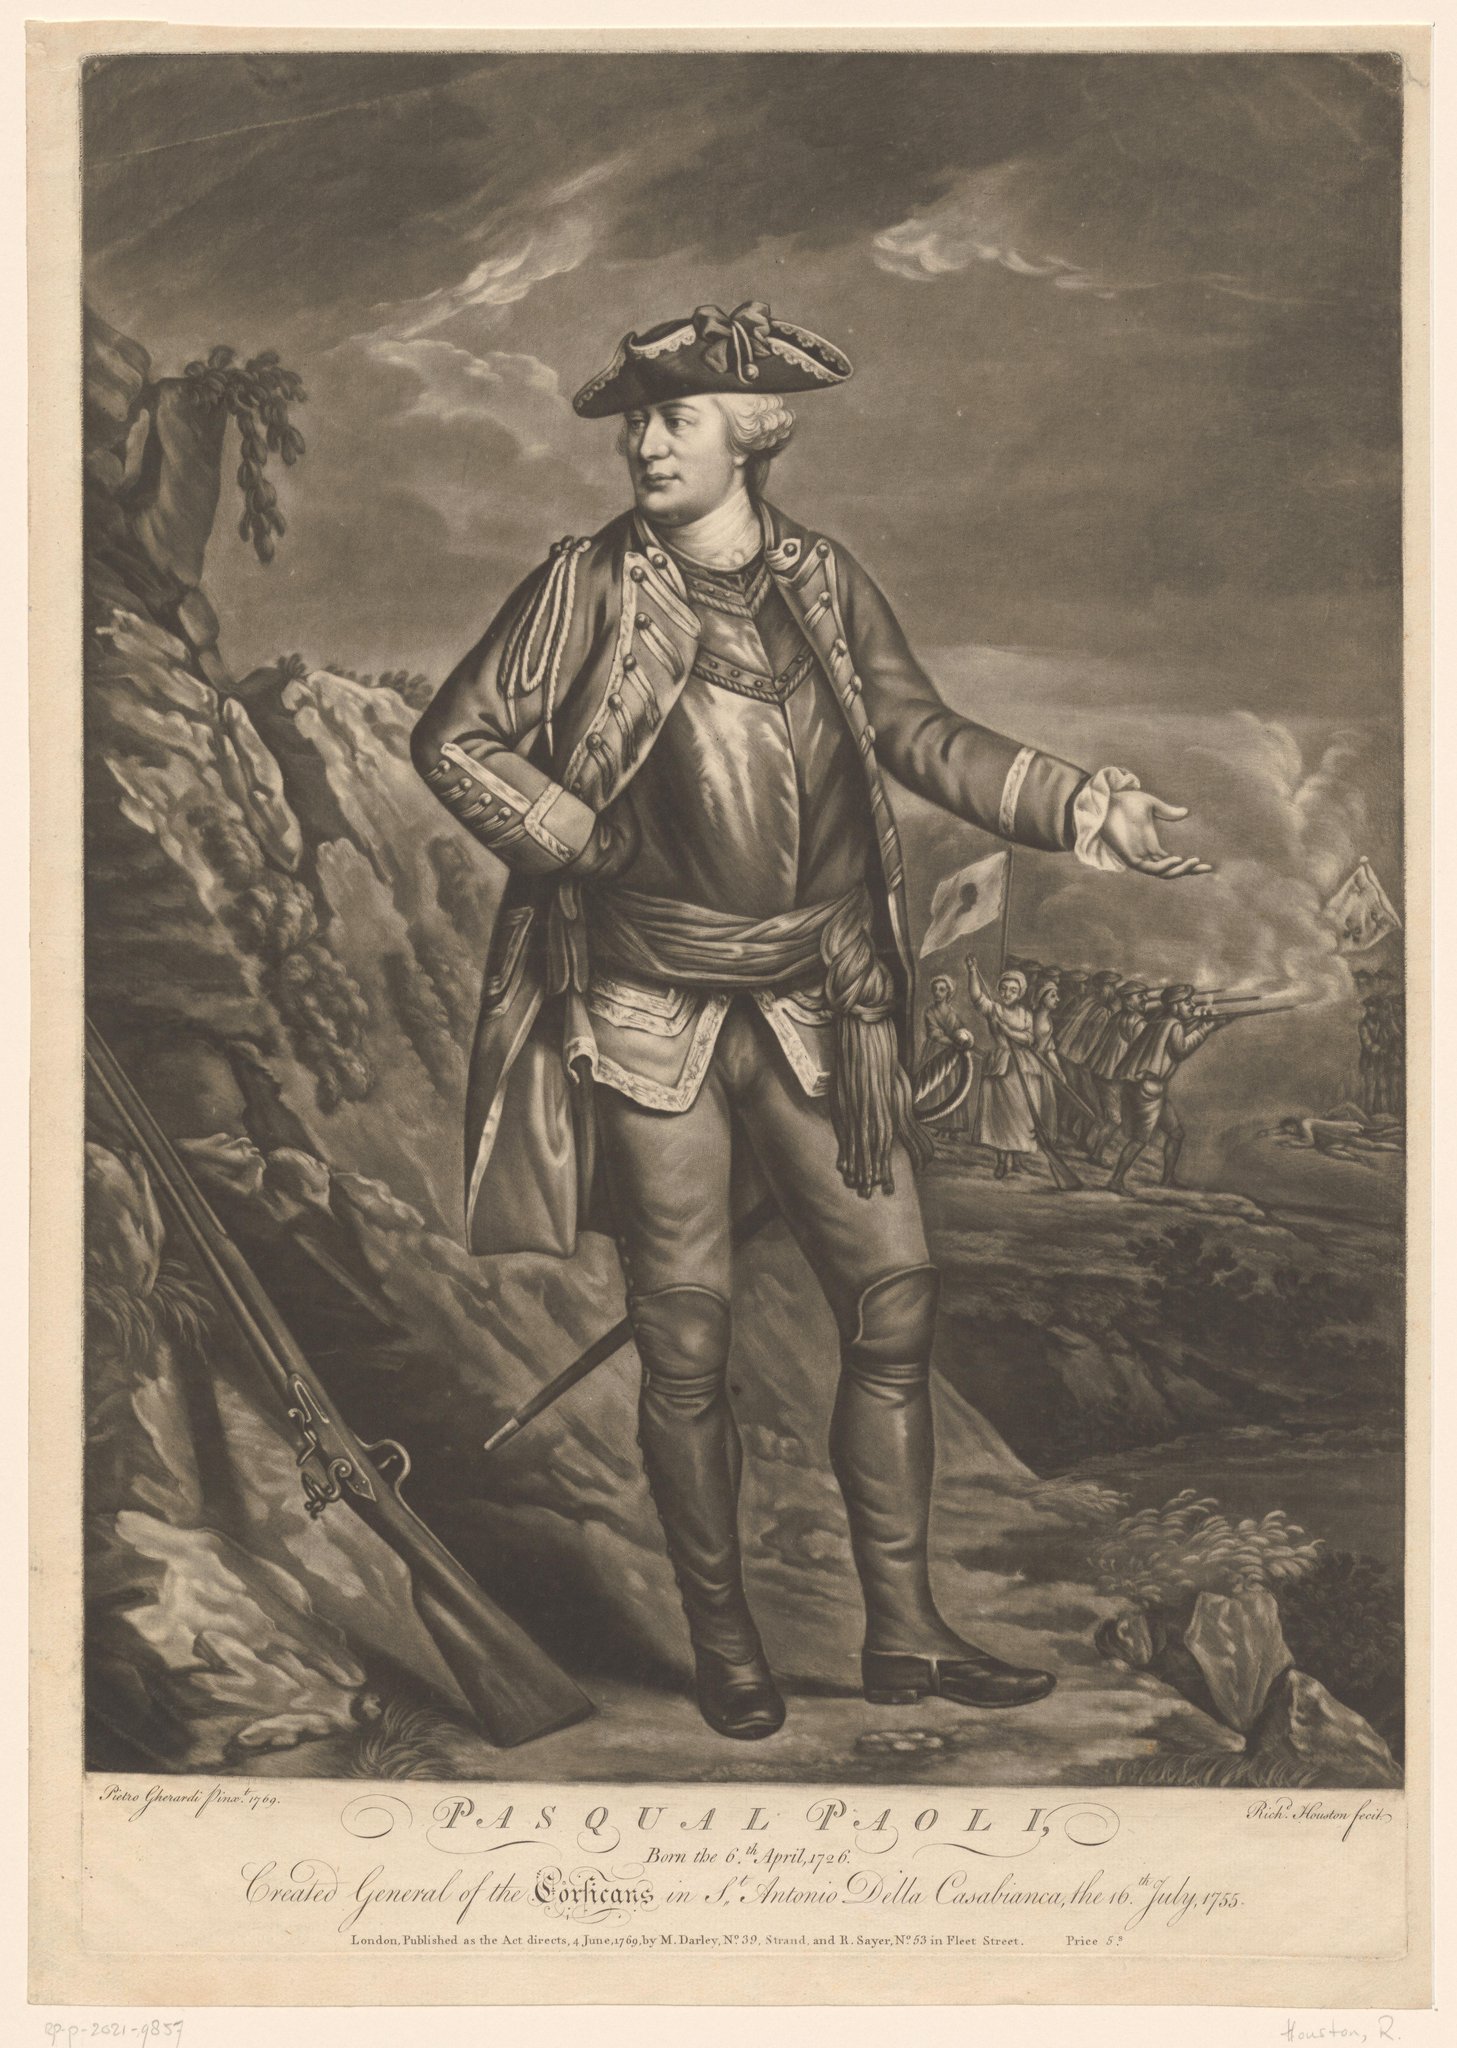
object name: print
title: Portret van Pasquale Paoli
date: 1769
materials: paper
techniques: engraving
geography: london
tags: commander-in-chief, general, marshal, adult man, historical persons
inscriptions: date